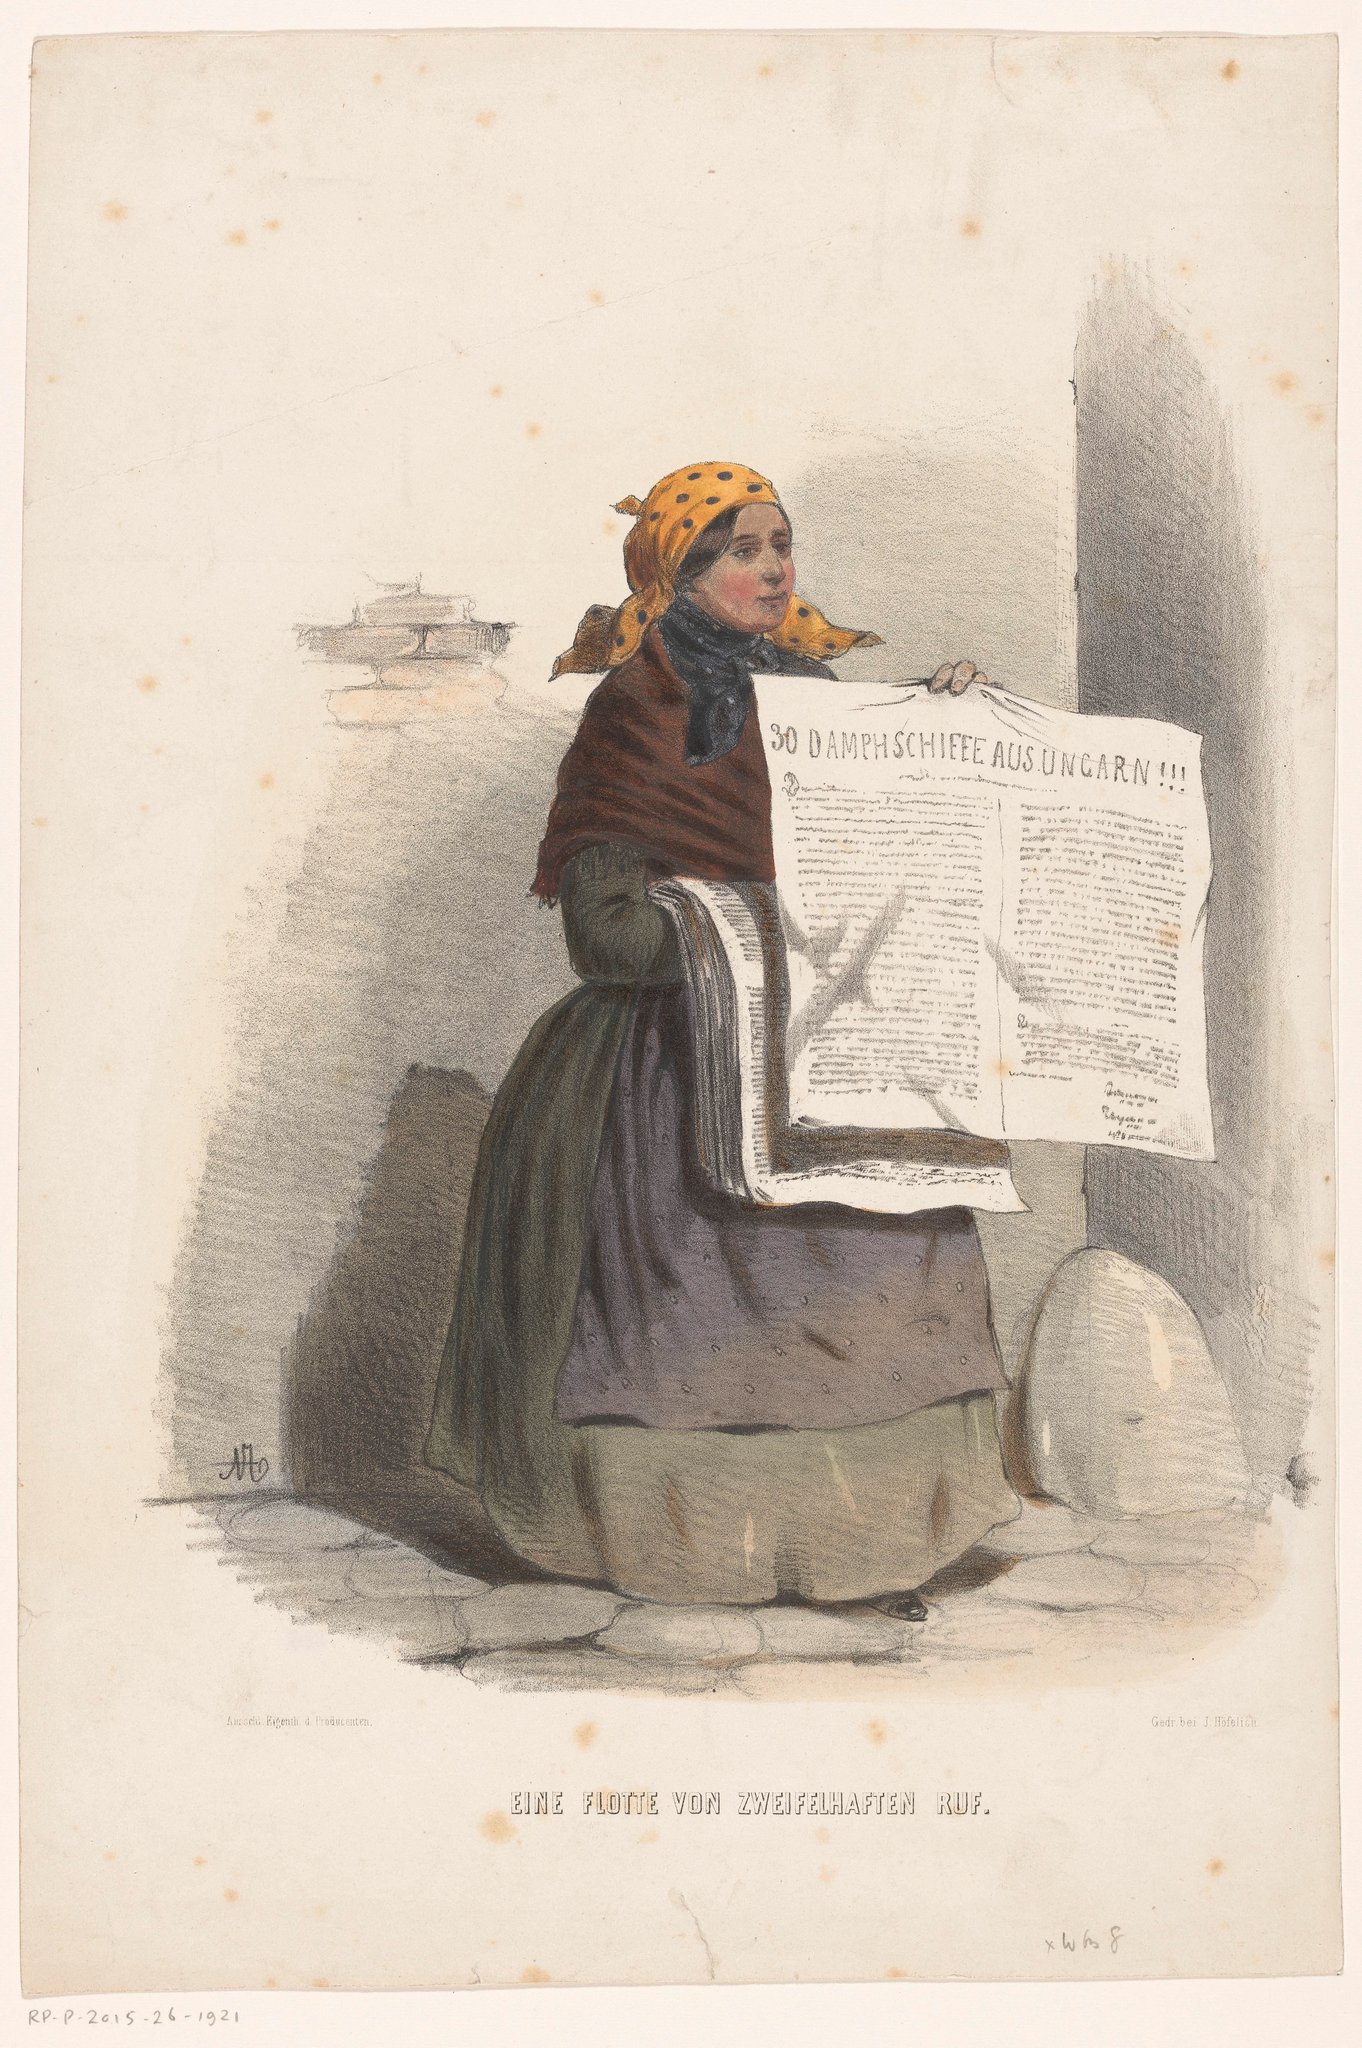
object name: print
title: Krantenverkoopster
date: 1850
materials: paper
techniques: hand coloring, lithograph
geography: vienna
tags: street-trader, newspaper, news-sheet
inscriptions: collector's mark: Lugt 2228, collector's mark: Lugt 4780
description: Straatgezicht met een krantenverkoopster, een vrouw met een sjaal en een hoofddoek. In haar linkerhand houdt ze een opengevouwen krant met de kop: '30 Damphschiffe aus Ungarn!!!'.